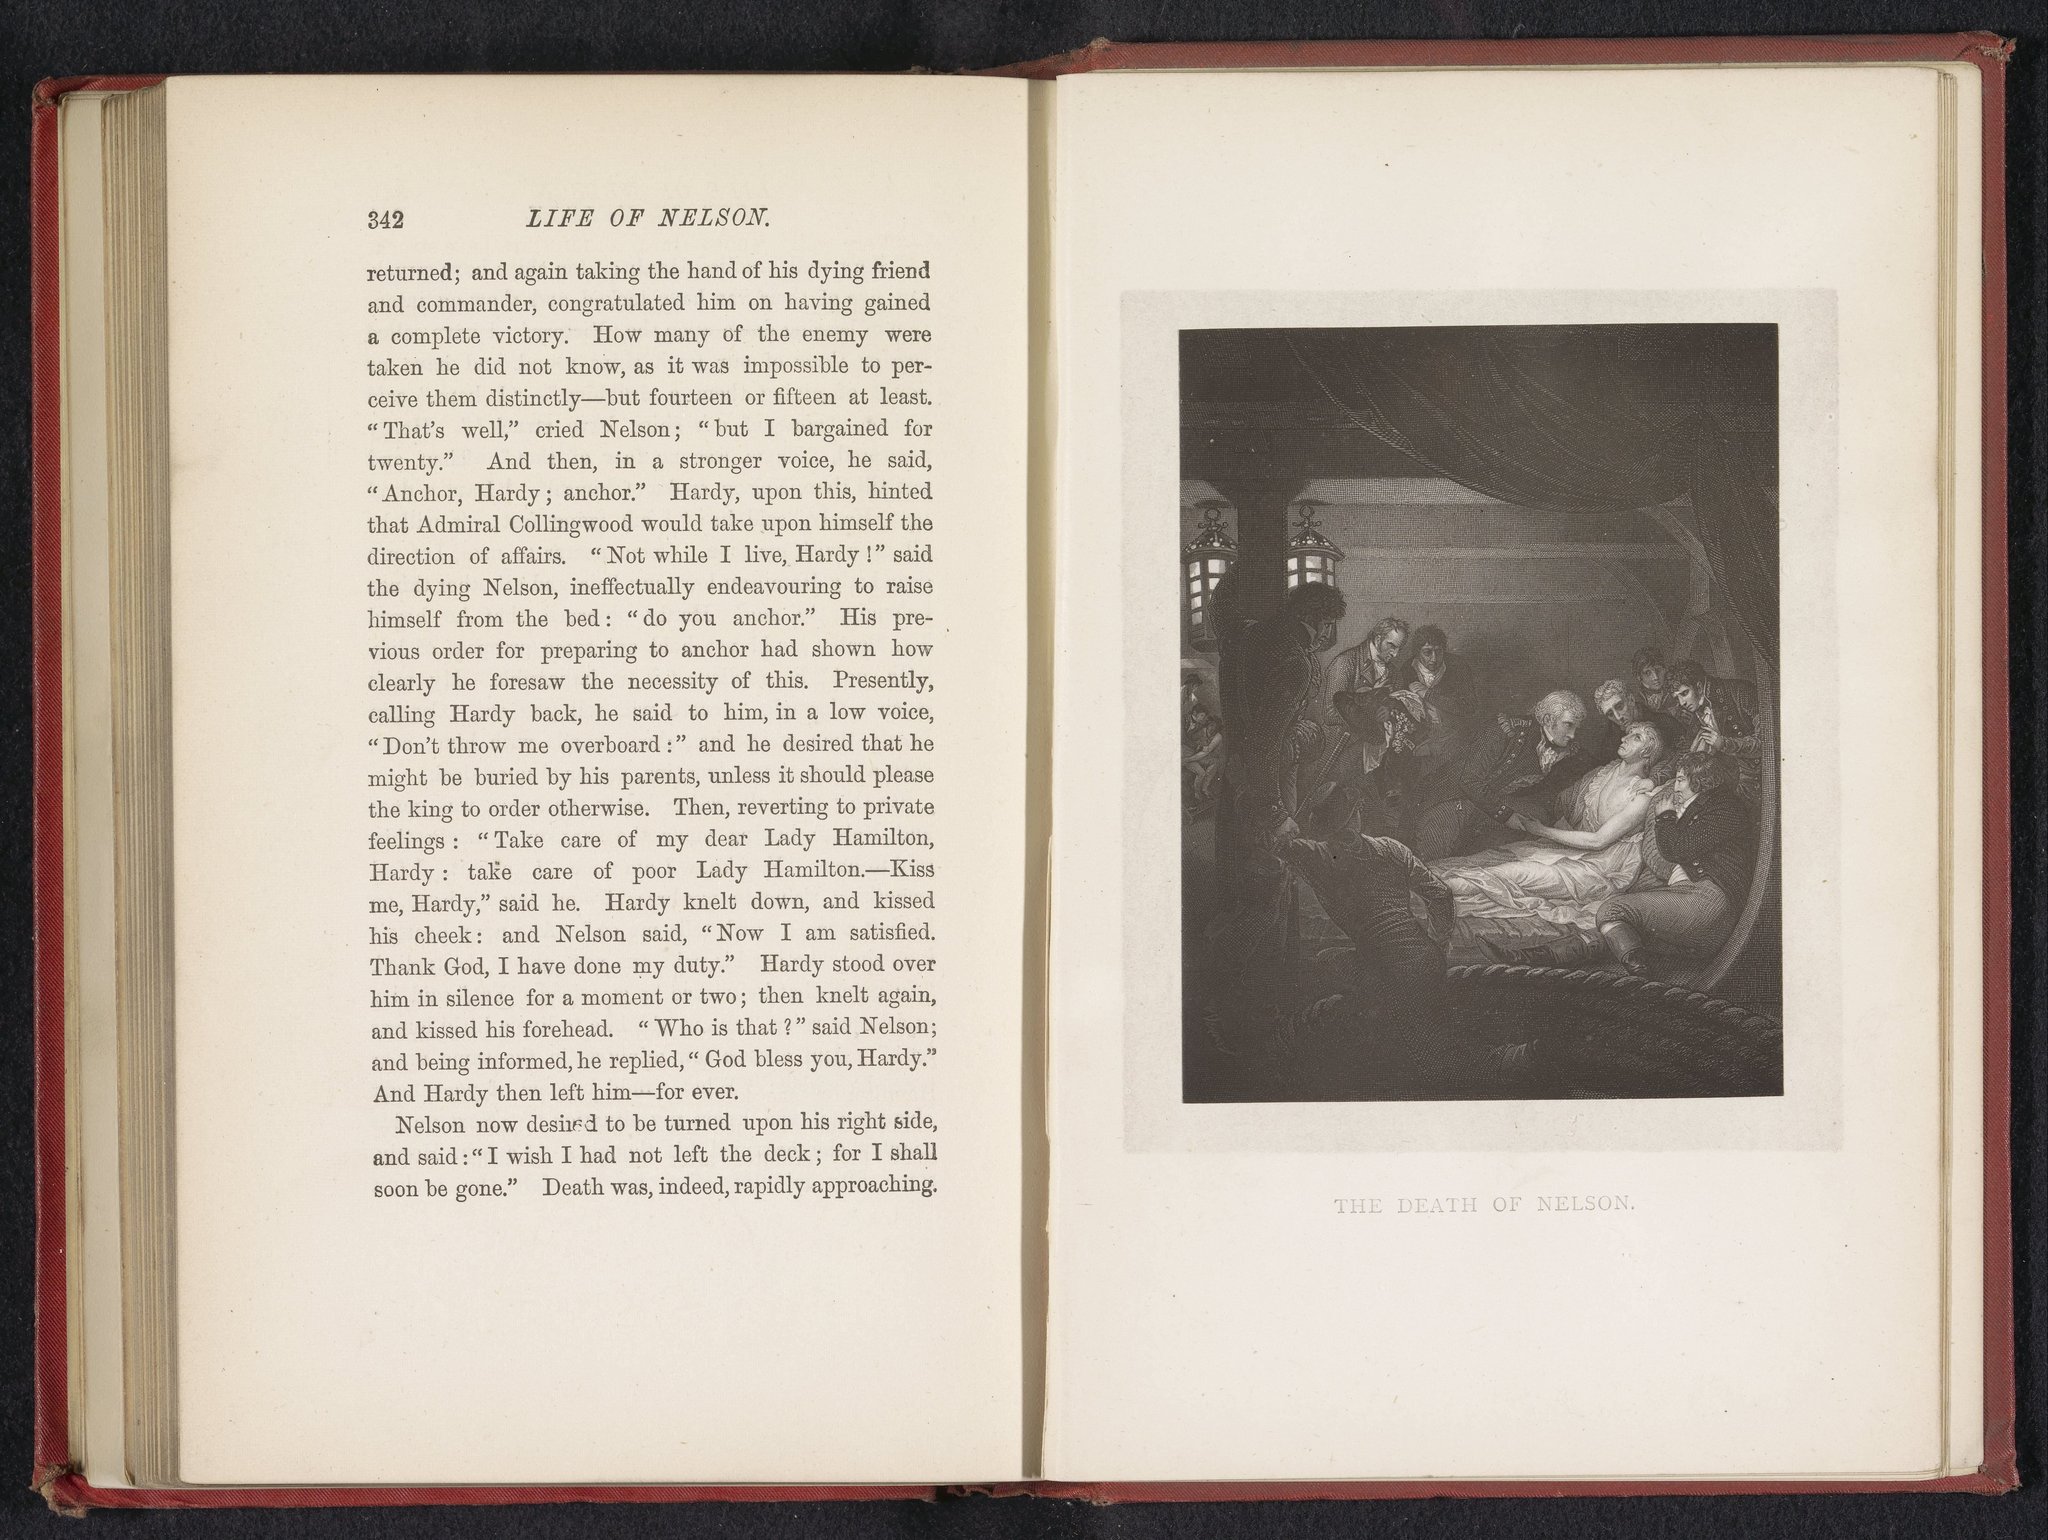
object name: page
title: Fotoreproductie van een prent van de dood van Horatio Nelson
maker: Anonymous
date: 1877-1887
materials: paper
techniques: woodburytype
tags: horatio nelson (hertog van bronte), death of human being